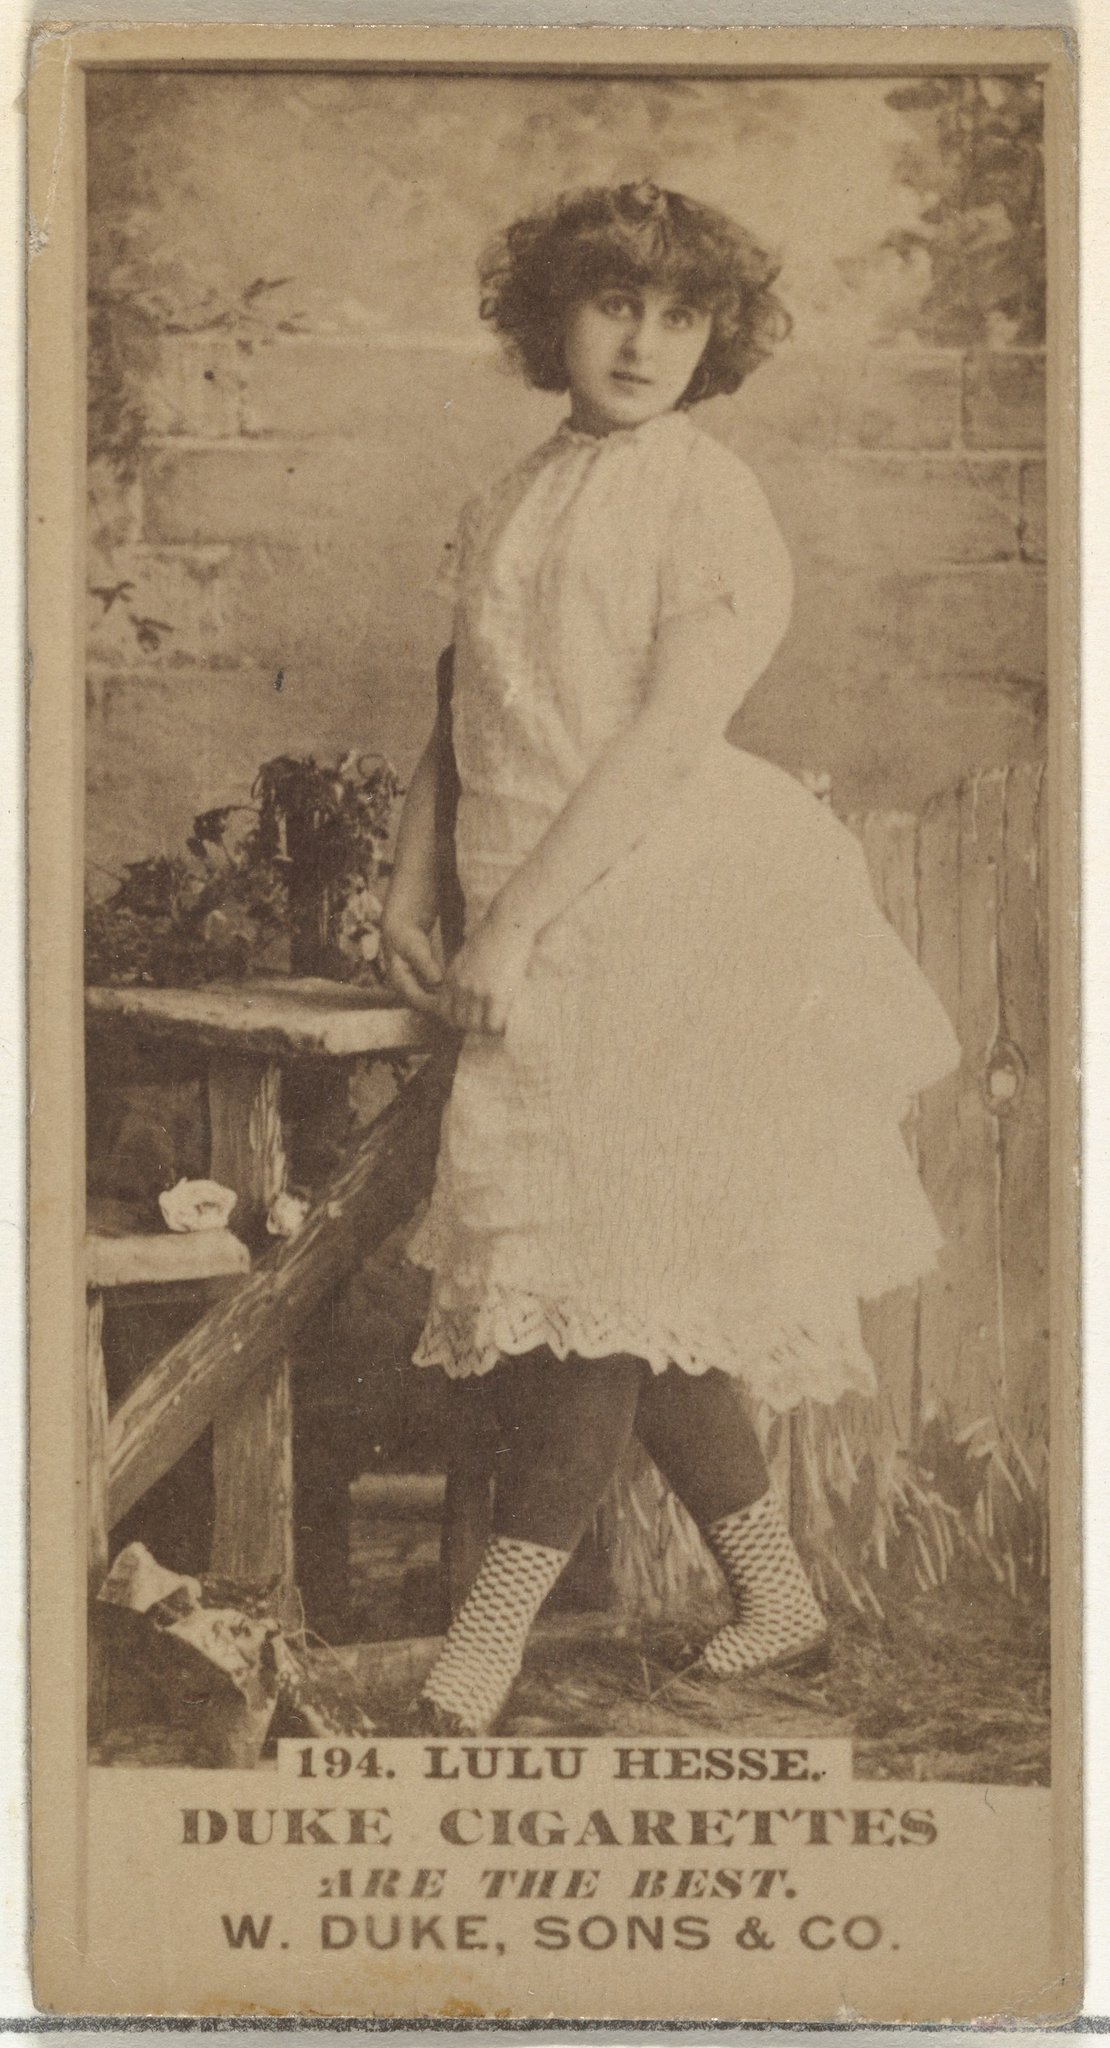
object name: photograph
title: Card Number 194, Lulu Hesse, from the Actors and Actresses series (N145-7) issued by Duke Sons & Co. to promote Duke Cigarettes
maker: w. duke, sons & co.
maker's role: publisher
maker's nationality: american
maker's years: 1870-1920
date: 1880-1889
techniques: albumen silver print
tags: portraits,women,actresses